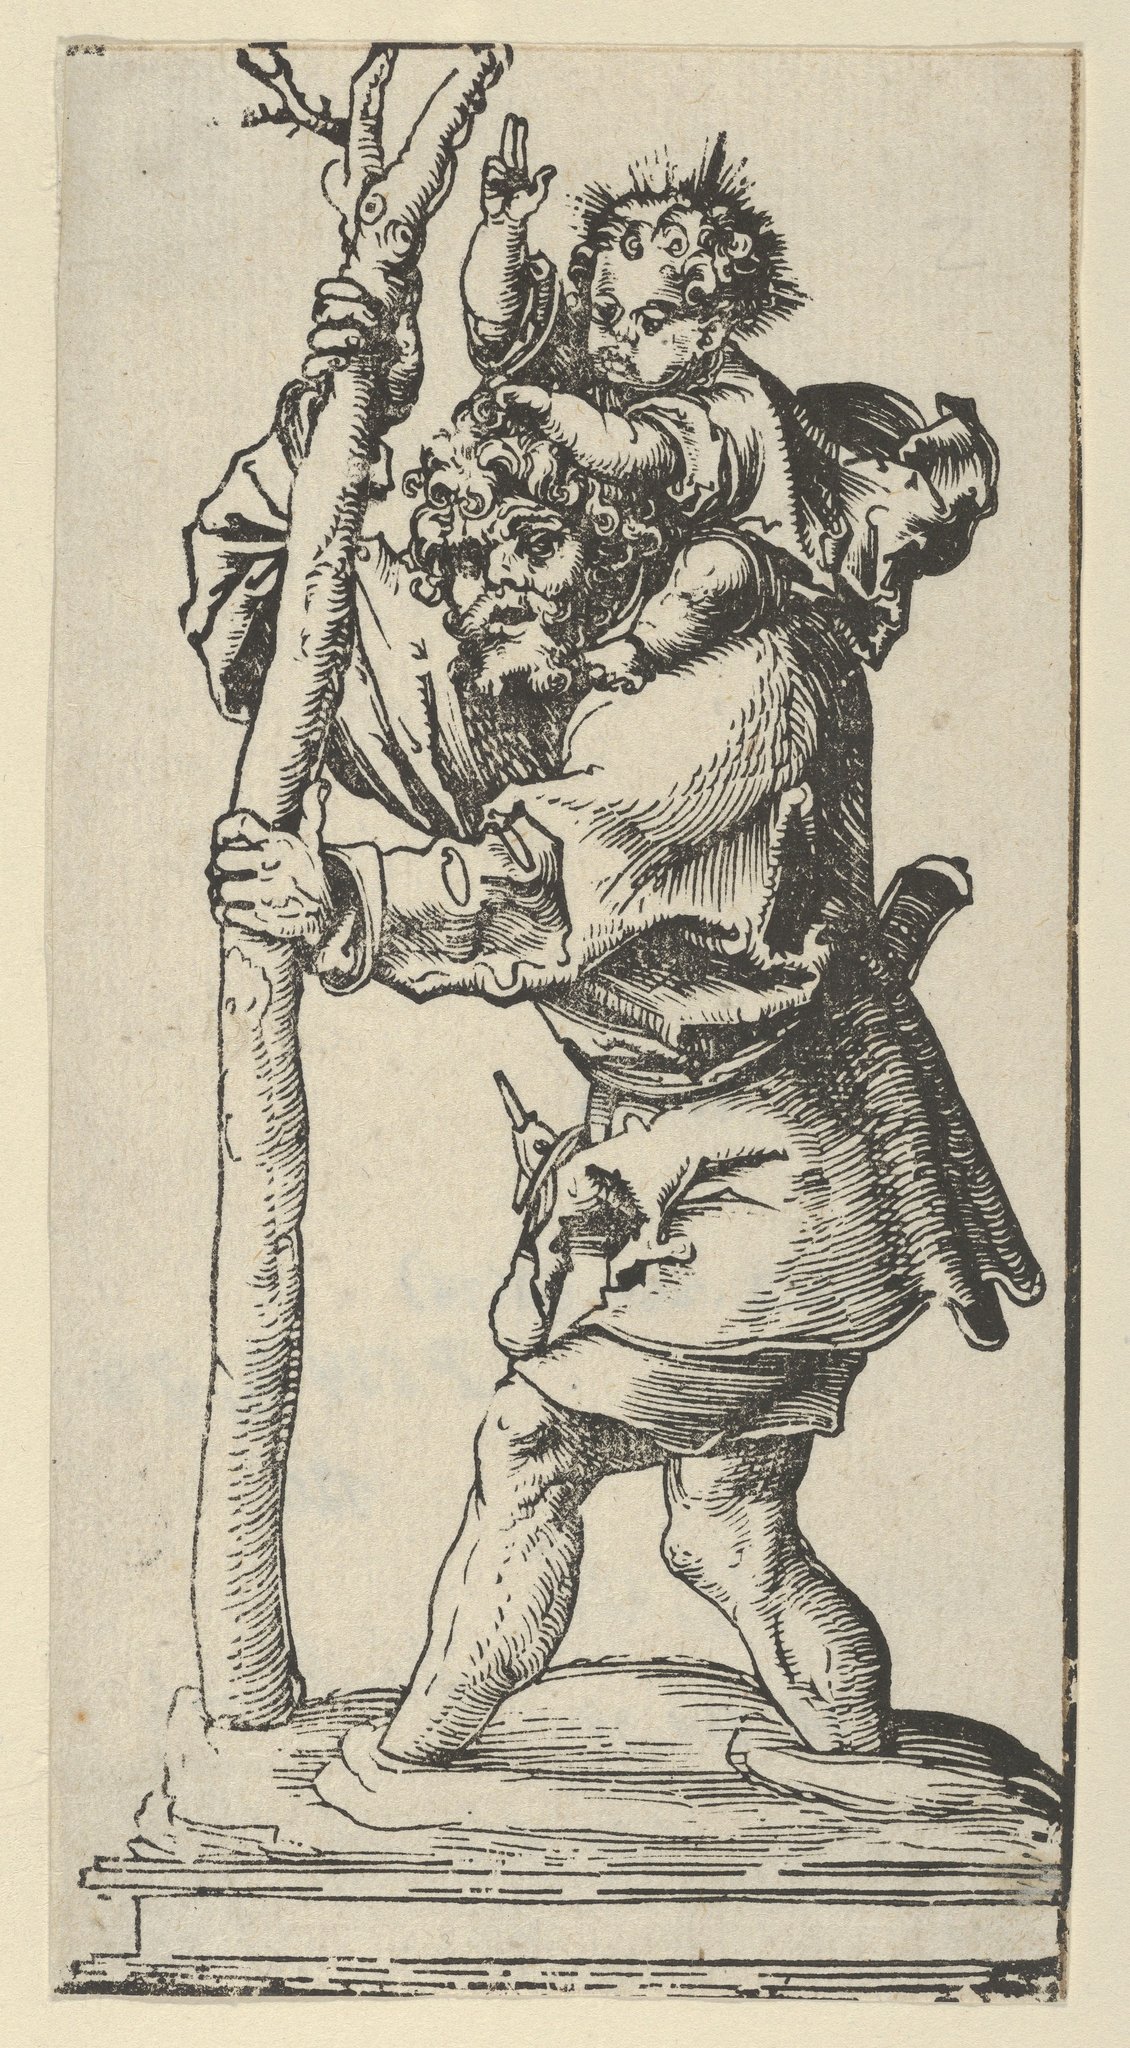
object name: print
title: A Silver Statuette of St. Christopher, from the Wittenberg Reliquaries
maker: lucas cranach the elder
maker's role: artist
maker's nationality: german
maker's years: 1472-1553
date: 1472-1553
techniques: woodcut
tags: christ,saint christopher